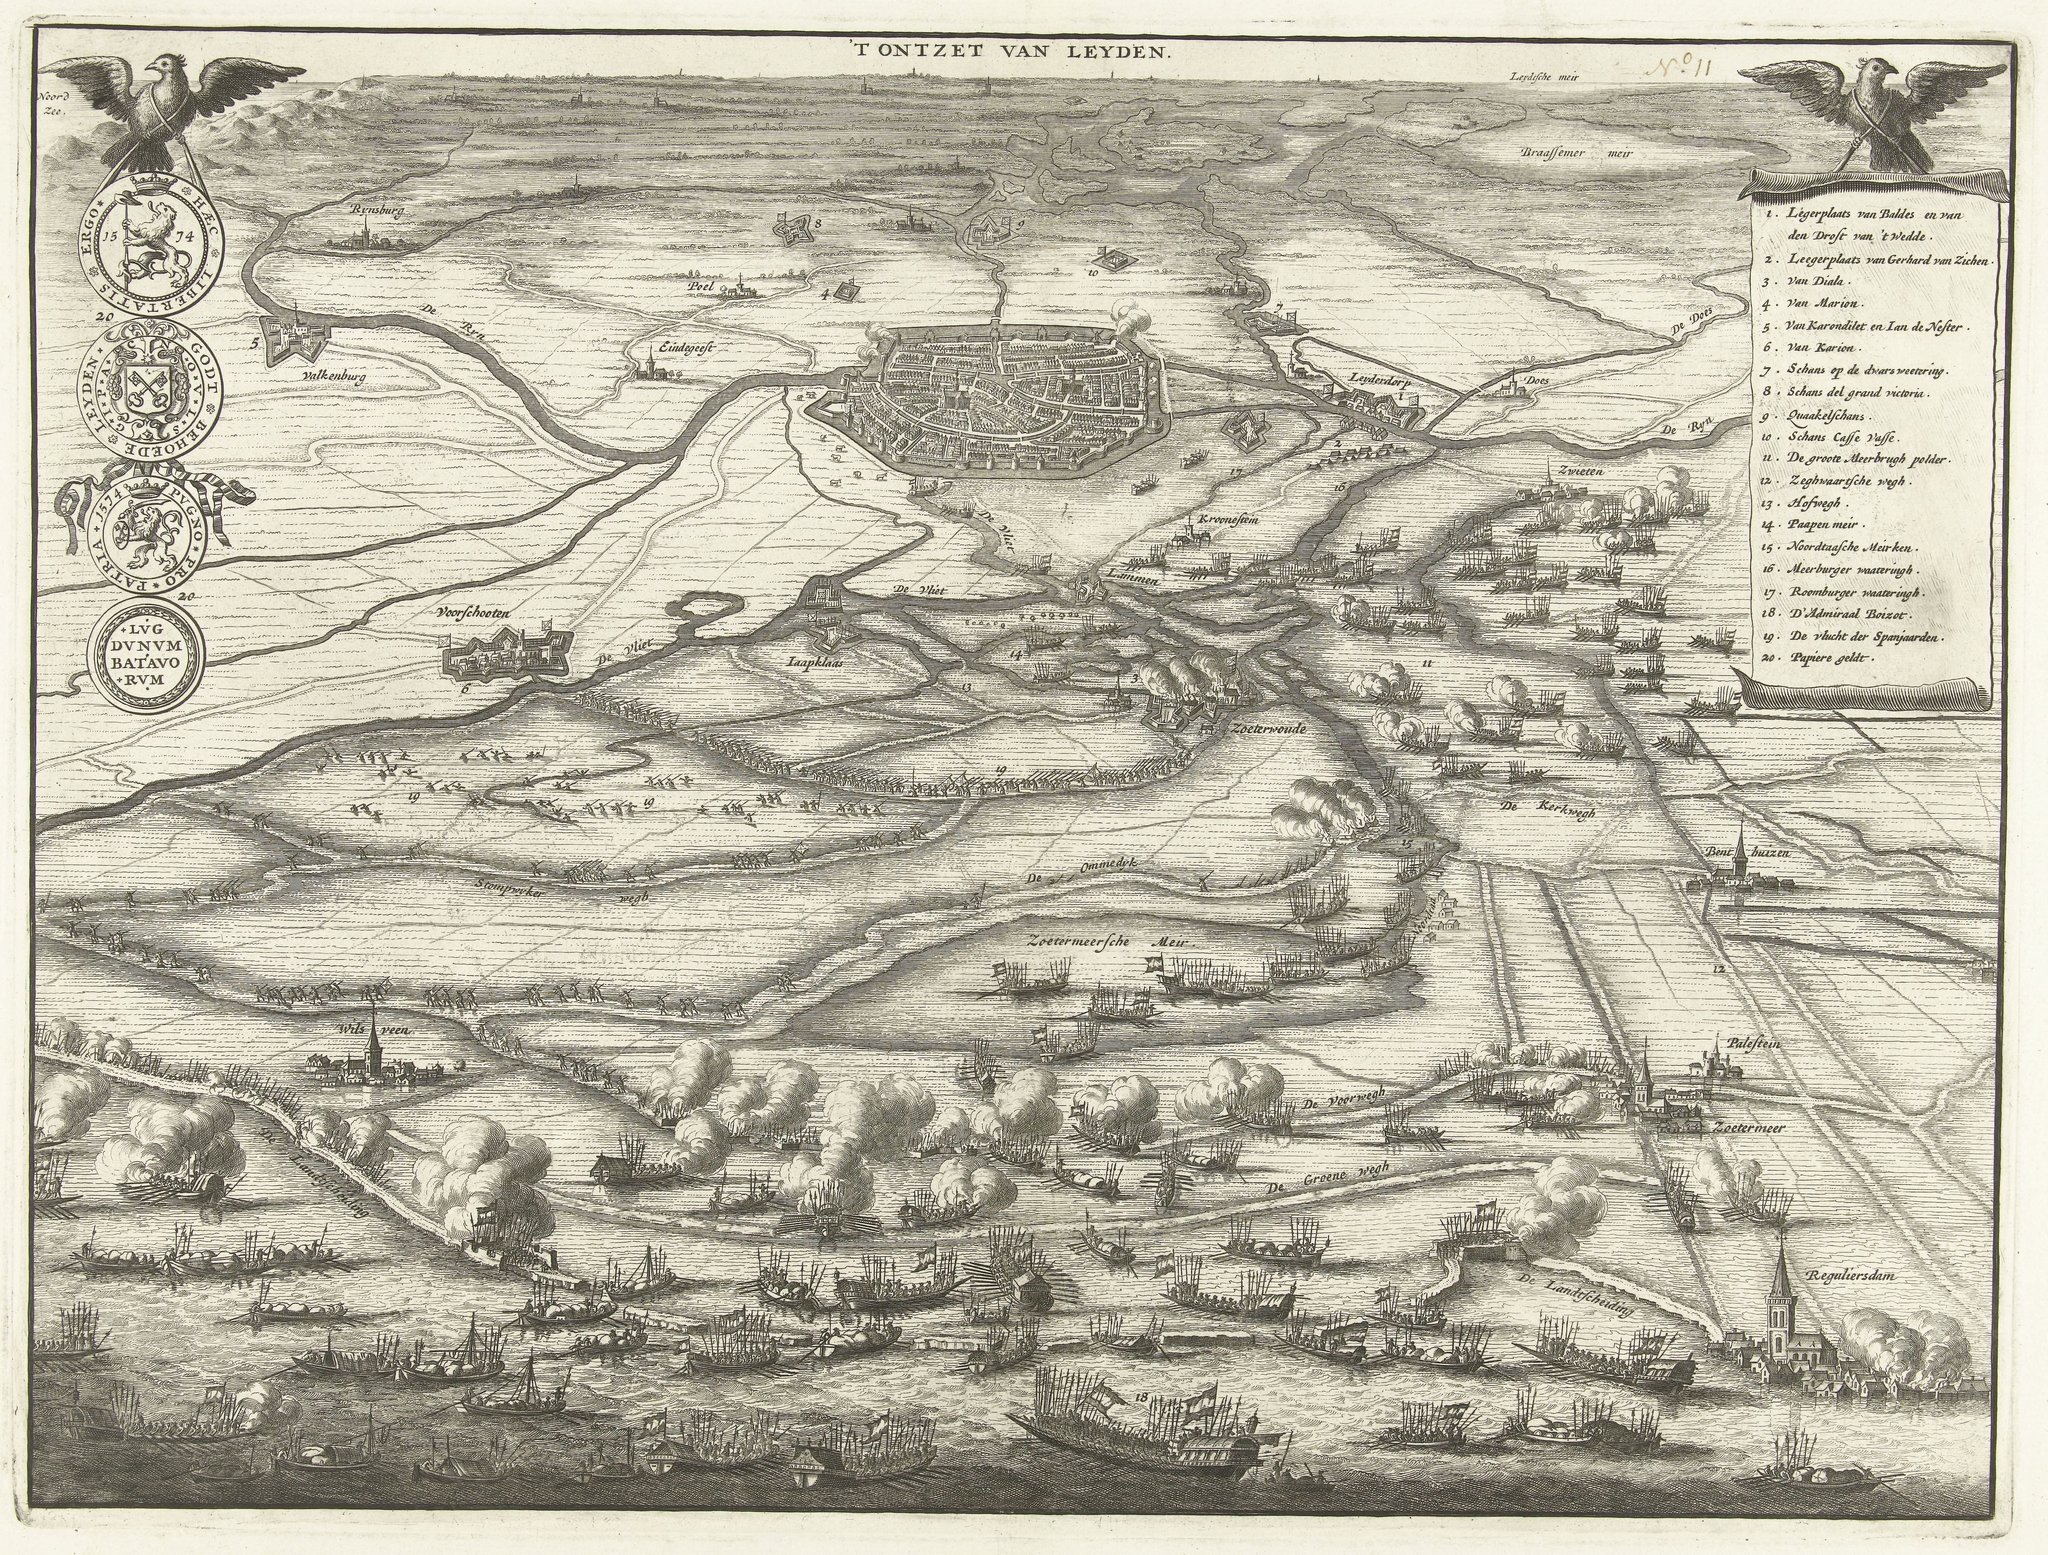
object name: print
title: Kaart met het ontzet van Leiden, 1574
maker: coenraet decker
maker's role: print maker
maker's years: 1650-1685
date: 1703-1730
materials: paper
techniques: etching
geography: amsterdam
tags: raising the siege with outside assistance, relief, maps of separate countries or regions, battle, leiden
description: Eerdere staat ook gebruikt in: Goris, Johan. Hugo de Groots Nederlandtsche Jaerboeken en Historien. Amsterdam: weduwe Johan van Someren, Abraham Wolfgang en Hendrik en Dirk Boom, 1681, tussen p. 48 en 49. En in: P.C. Hoofts Nederlandsche historien, seedert de ooverdraght der heerschappye van kaizar Karel den Vyfden op koning Philips zynen zoon, tot het einde der landtvooghdye des graven van Leicester. 4e druk. 2 delen. Amsterdam: Hendrik Wetstein en Pieter Sceperus, Leiden: Daniel van den Dalen en Utrecht: Willem van de Water, 1703, dl. 1, tussen p. 394 en 395. Latere staat ook gebruikt in: Clerc, Jean le. Geschiedenissen der Vereenigde Nederlanden, sedert den aanvang van die Republyk tot op den Vrede van Utrecht in 't jaar 1713 […]. 3 delen. Amsterdam: Zacharias Chatelain, 1730, dl. 1, tussen p. 60 en 61.